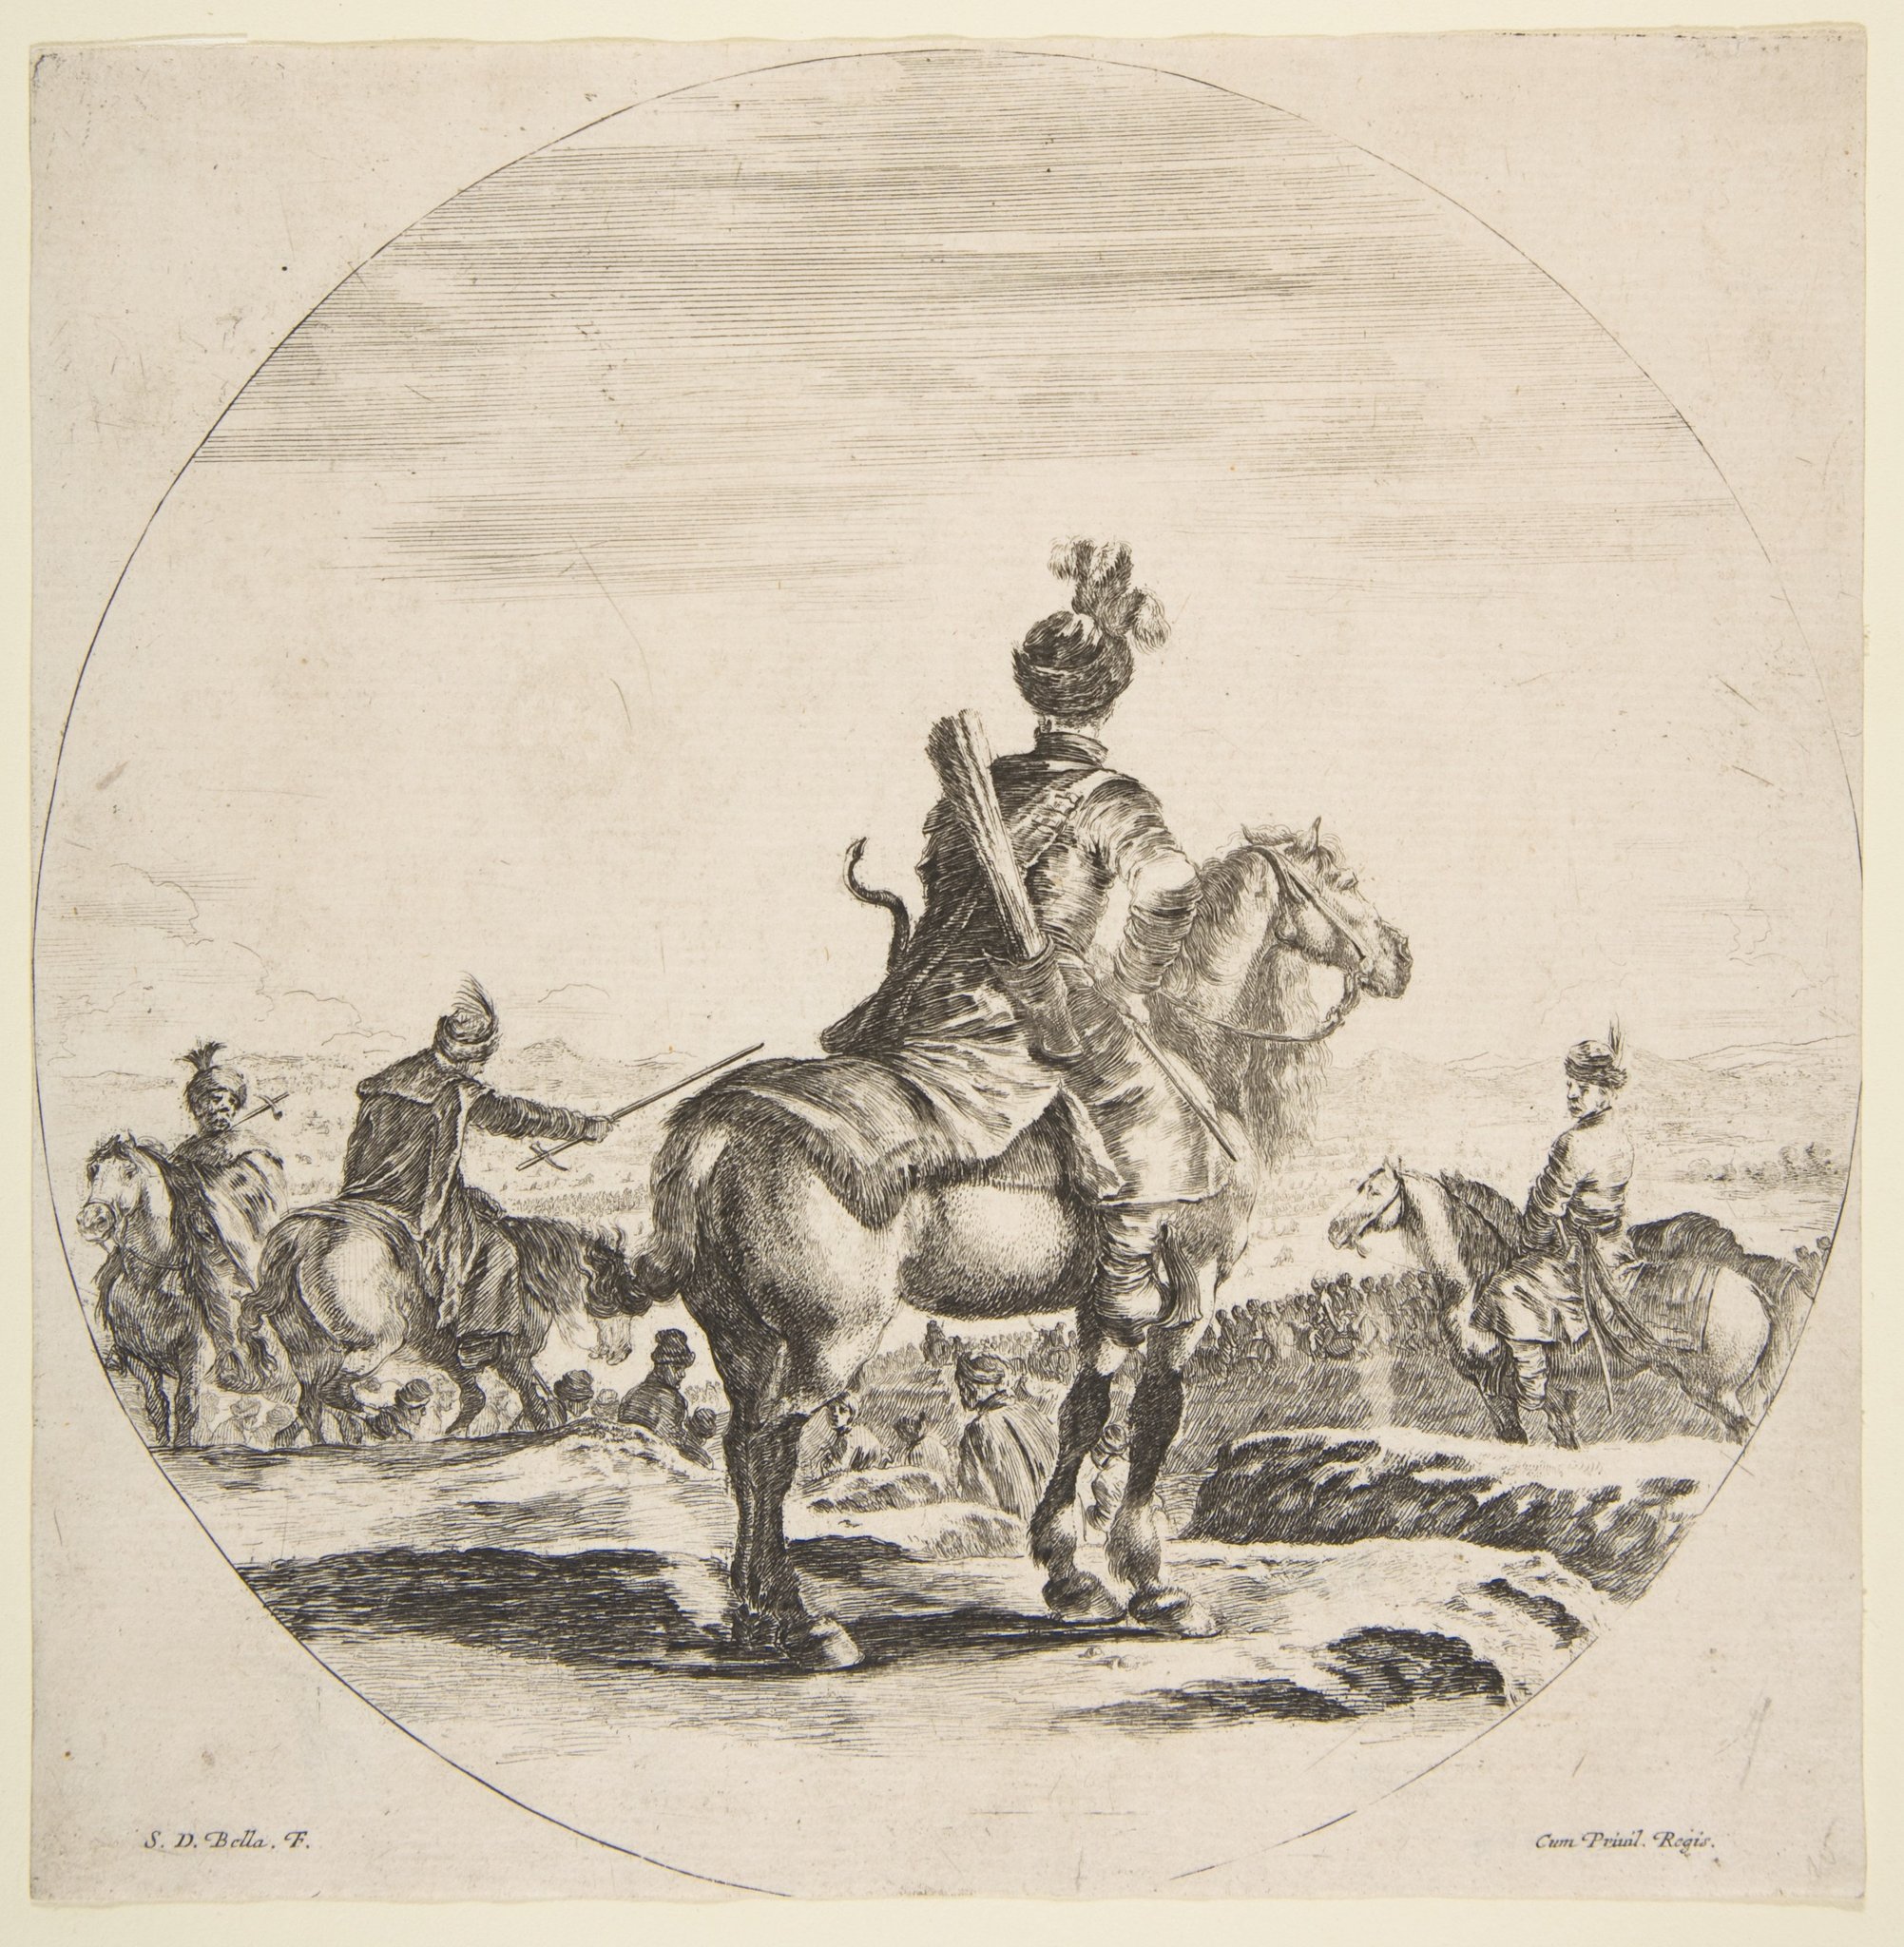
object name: print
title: Polish horseman with a bow and arrow, seen from behind with his horse facing right, a circular composition, from 'Figures on Horseback' (Cavaliers nègres, polonais et hongrois)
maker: stefano della bella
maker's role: artist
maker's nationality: italian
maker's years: 1610-1664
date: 1651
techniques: etching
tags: swords,men,horses